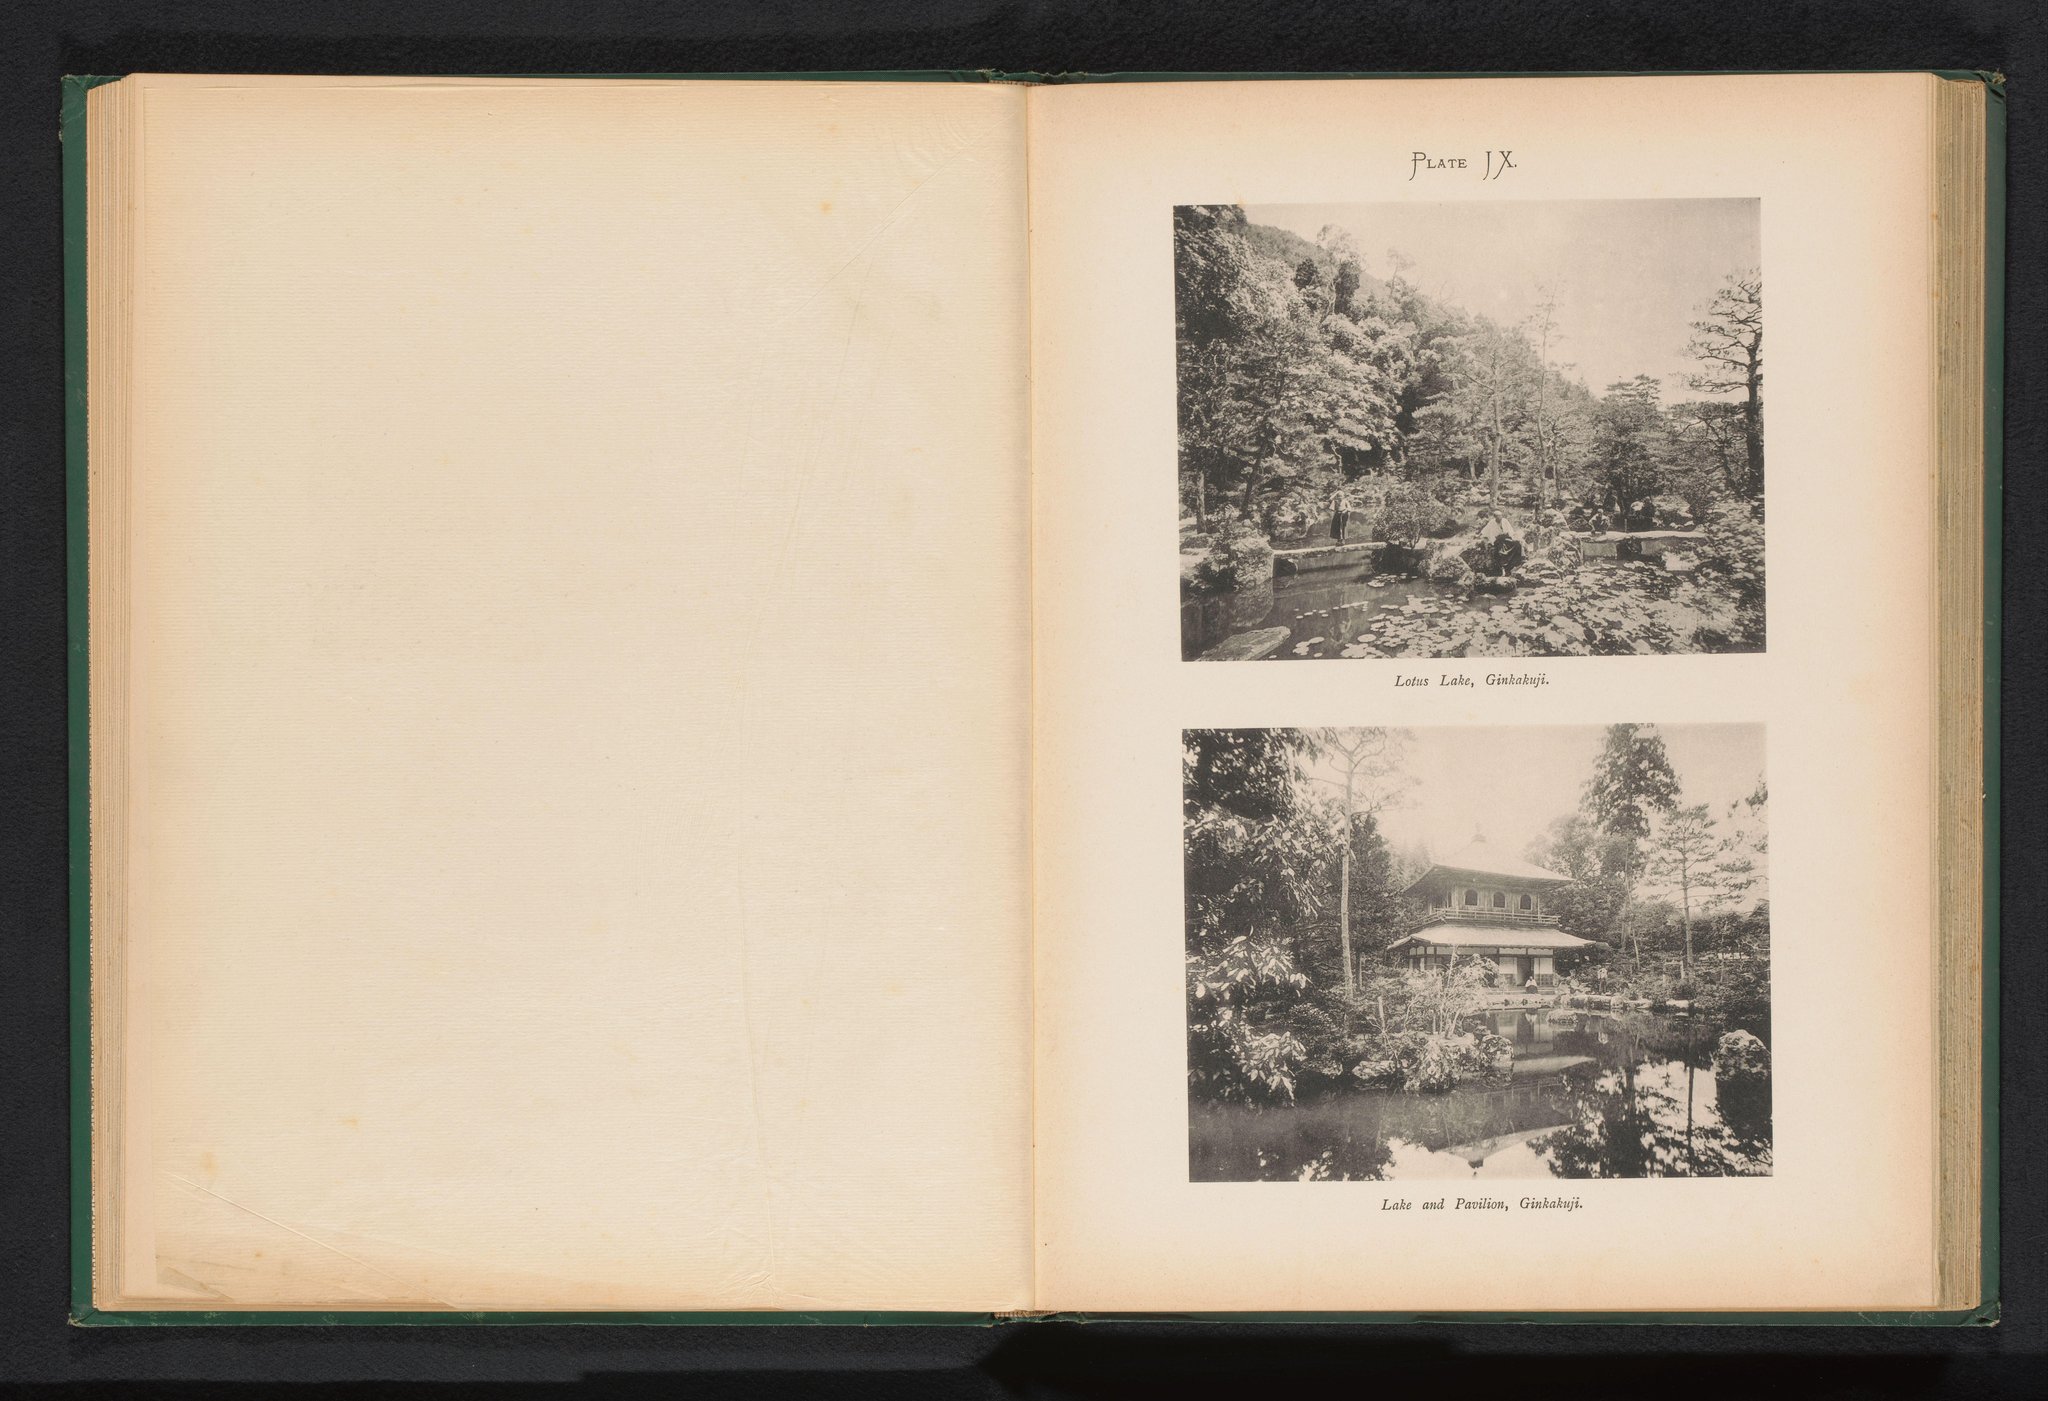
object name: photomechanical print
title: Twee gezichten op de Ginkaku-ji tempel en tuinen in Kyoto, Japan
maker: kazumasa ogawa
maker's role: auteur, fotograaf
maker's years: 1860-1929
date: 1888-1893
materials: paper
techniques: photograph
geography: kyoto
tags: temple, shrine ~ shinto, garden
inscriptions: inscription: ‘Plate IX.’